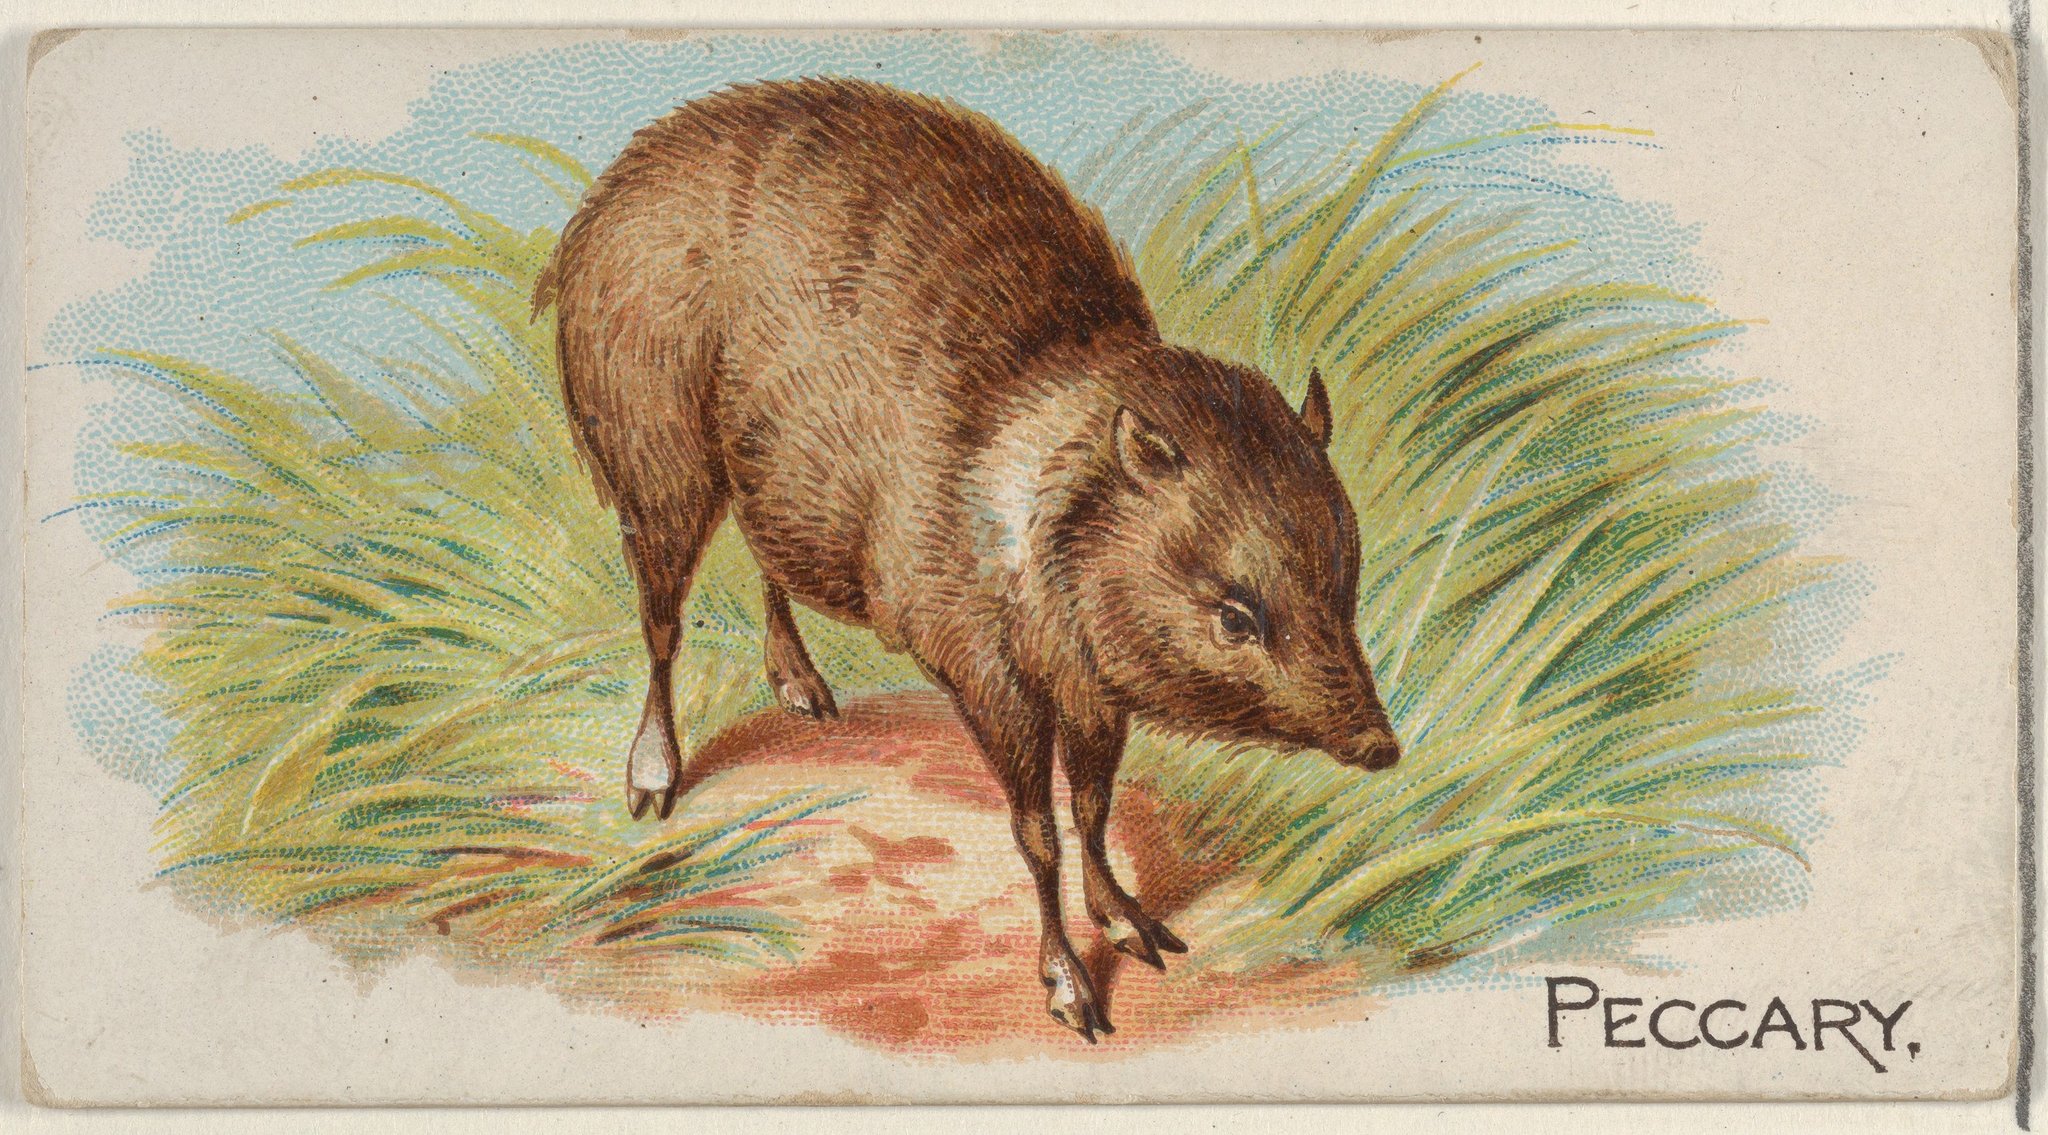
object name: print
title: Peccary, from the Quadrupeds series (N21) for Allen & Ginter Cigarettes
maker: allen & ginter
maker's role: publisher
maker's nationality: american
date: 1890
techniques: color lithograph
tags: animals